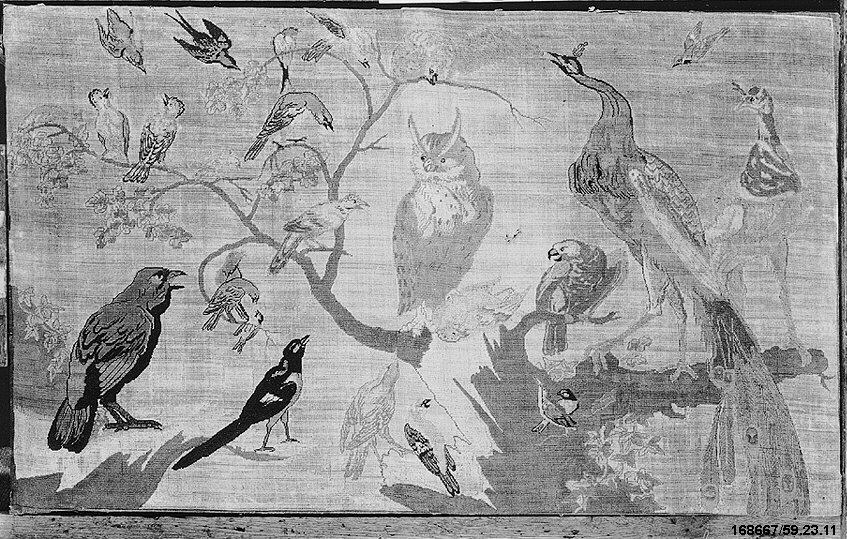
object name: piece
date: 1701-1800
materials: canvas, linen, silk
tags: owls,peacocks